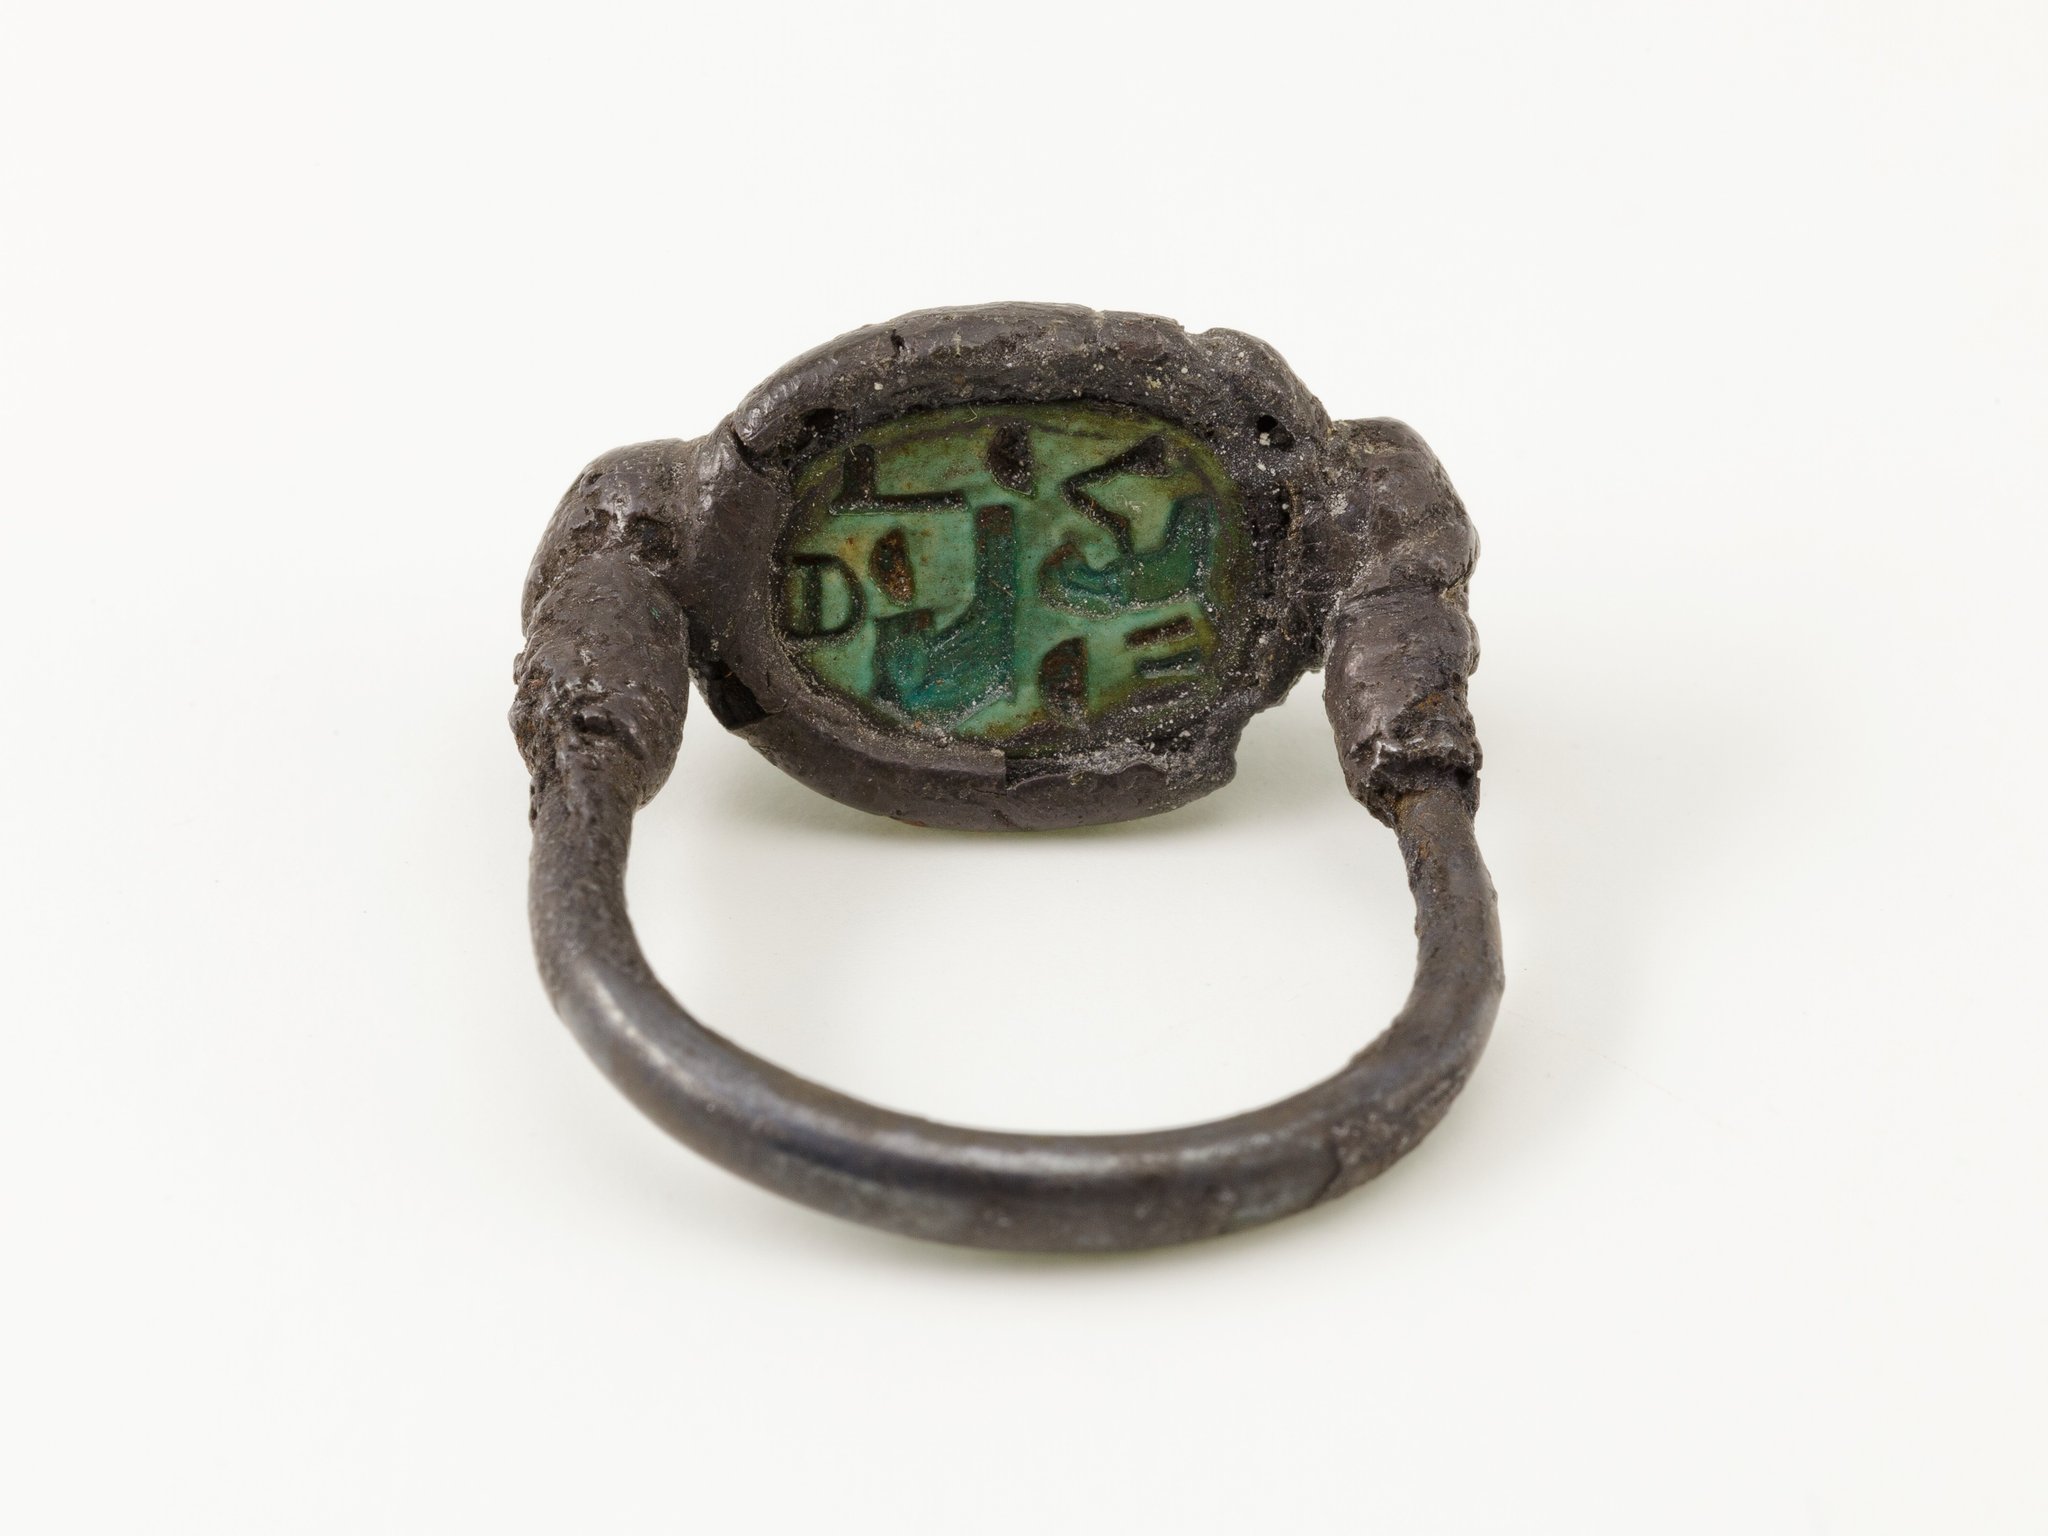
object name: ring, scarab, hatshepsut, god's wife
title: Scarab Finger Ring Inscribed "God's Wife Hatshepsut"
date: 1479-1458 BCE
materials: silver, stone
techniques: glazing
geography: egypt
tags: scarabs